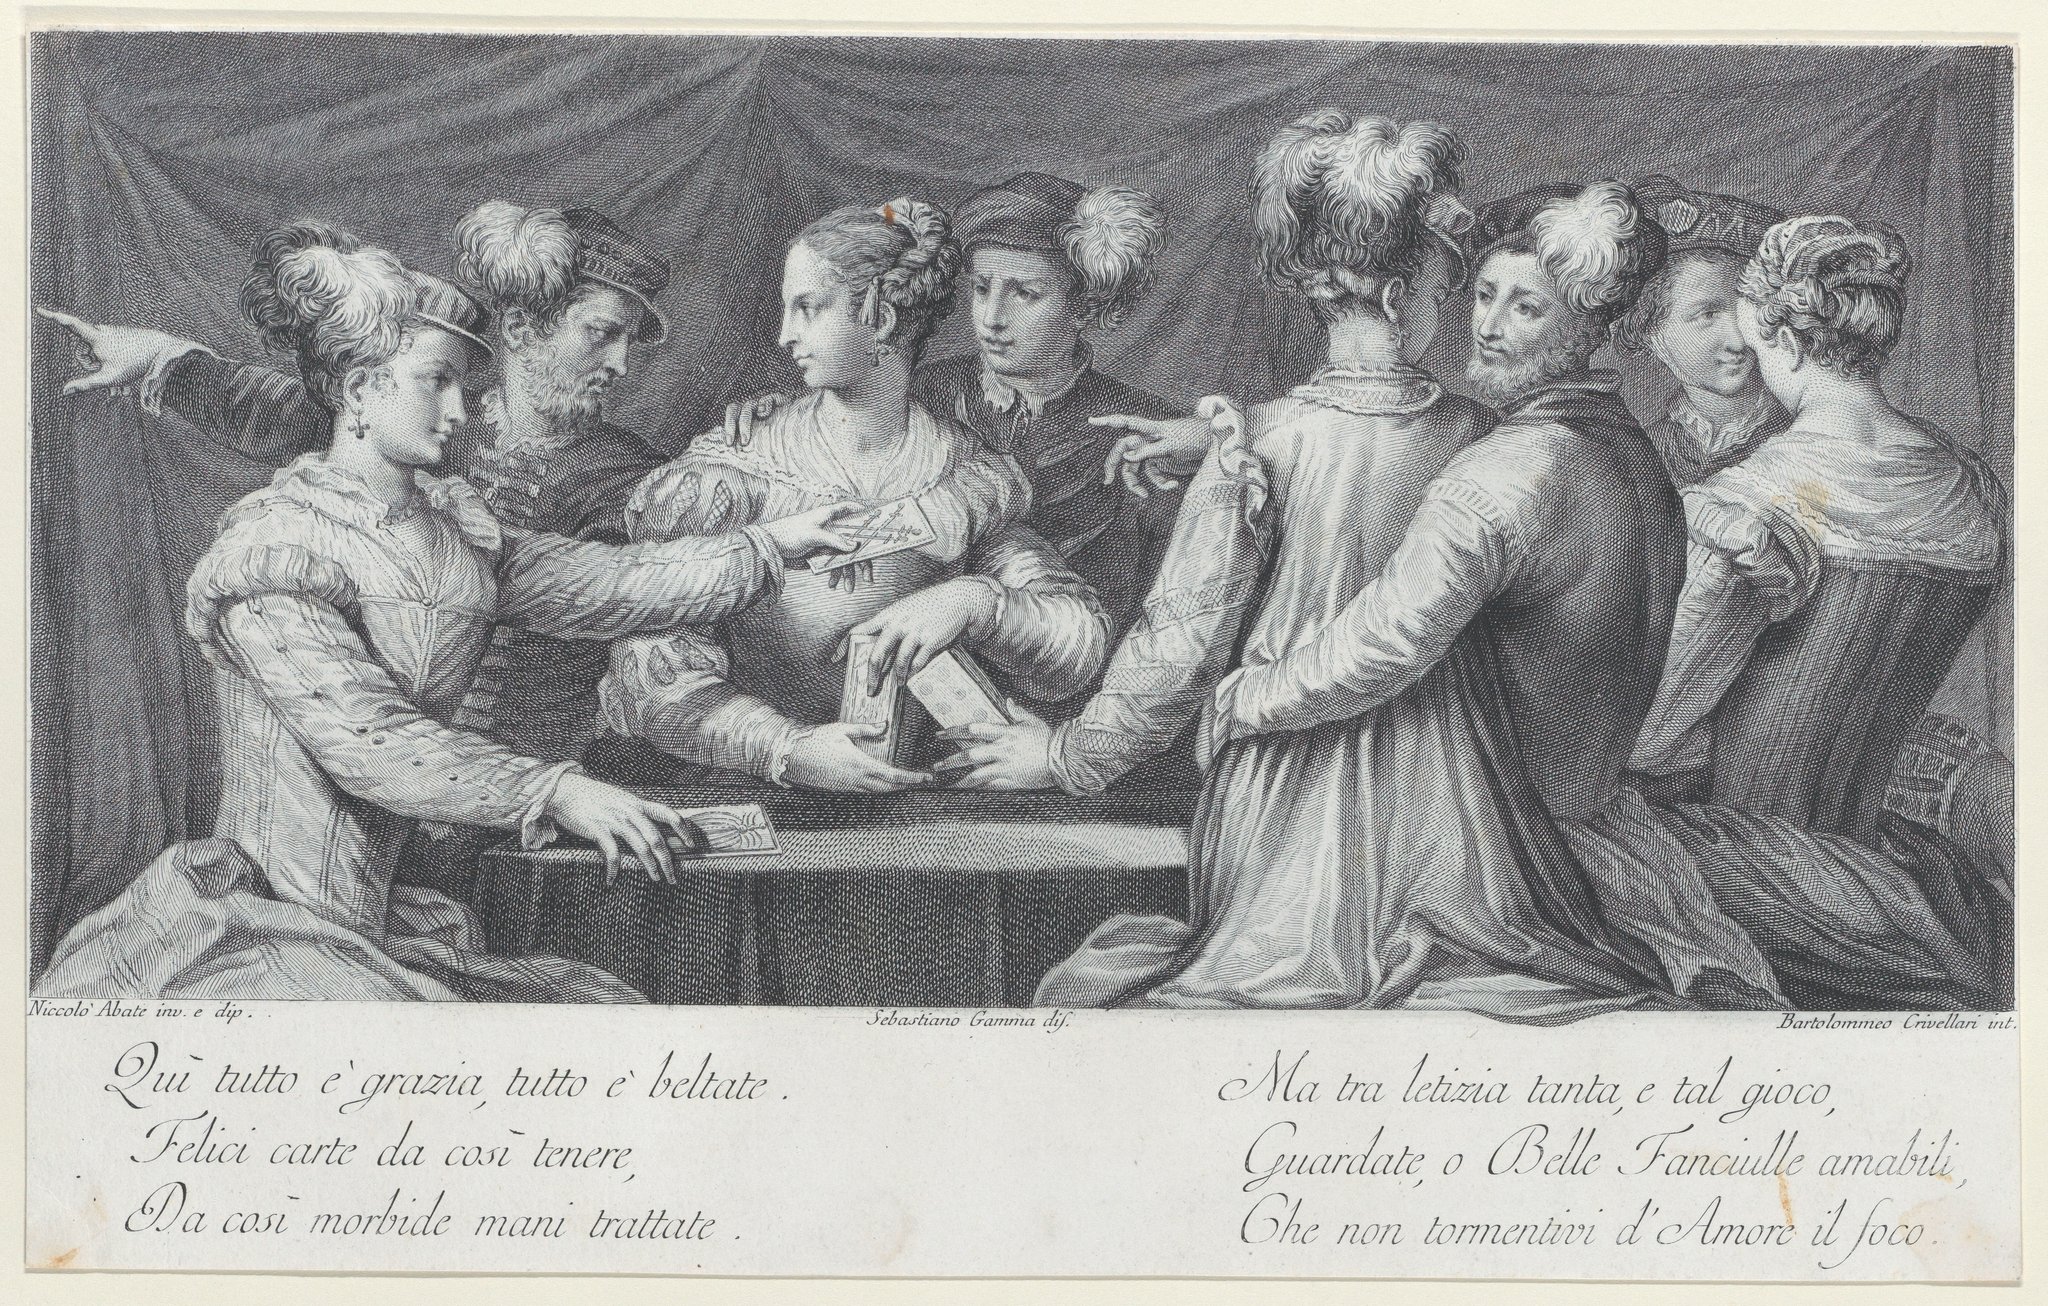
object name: print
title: A group of elegantly dressed people playing cards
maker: bartolomeo crivellari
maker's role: artist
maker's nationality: italian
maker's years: 1700-1800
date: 1740-1768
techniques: engraving